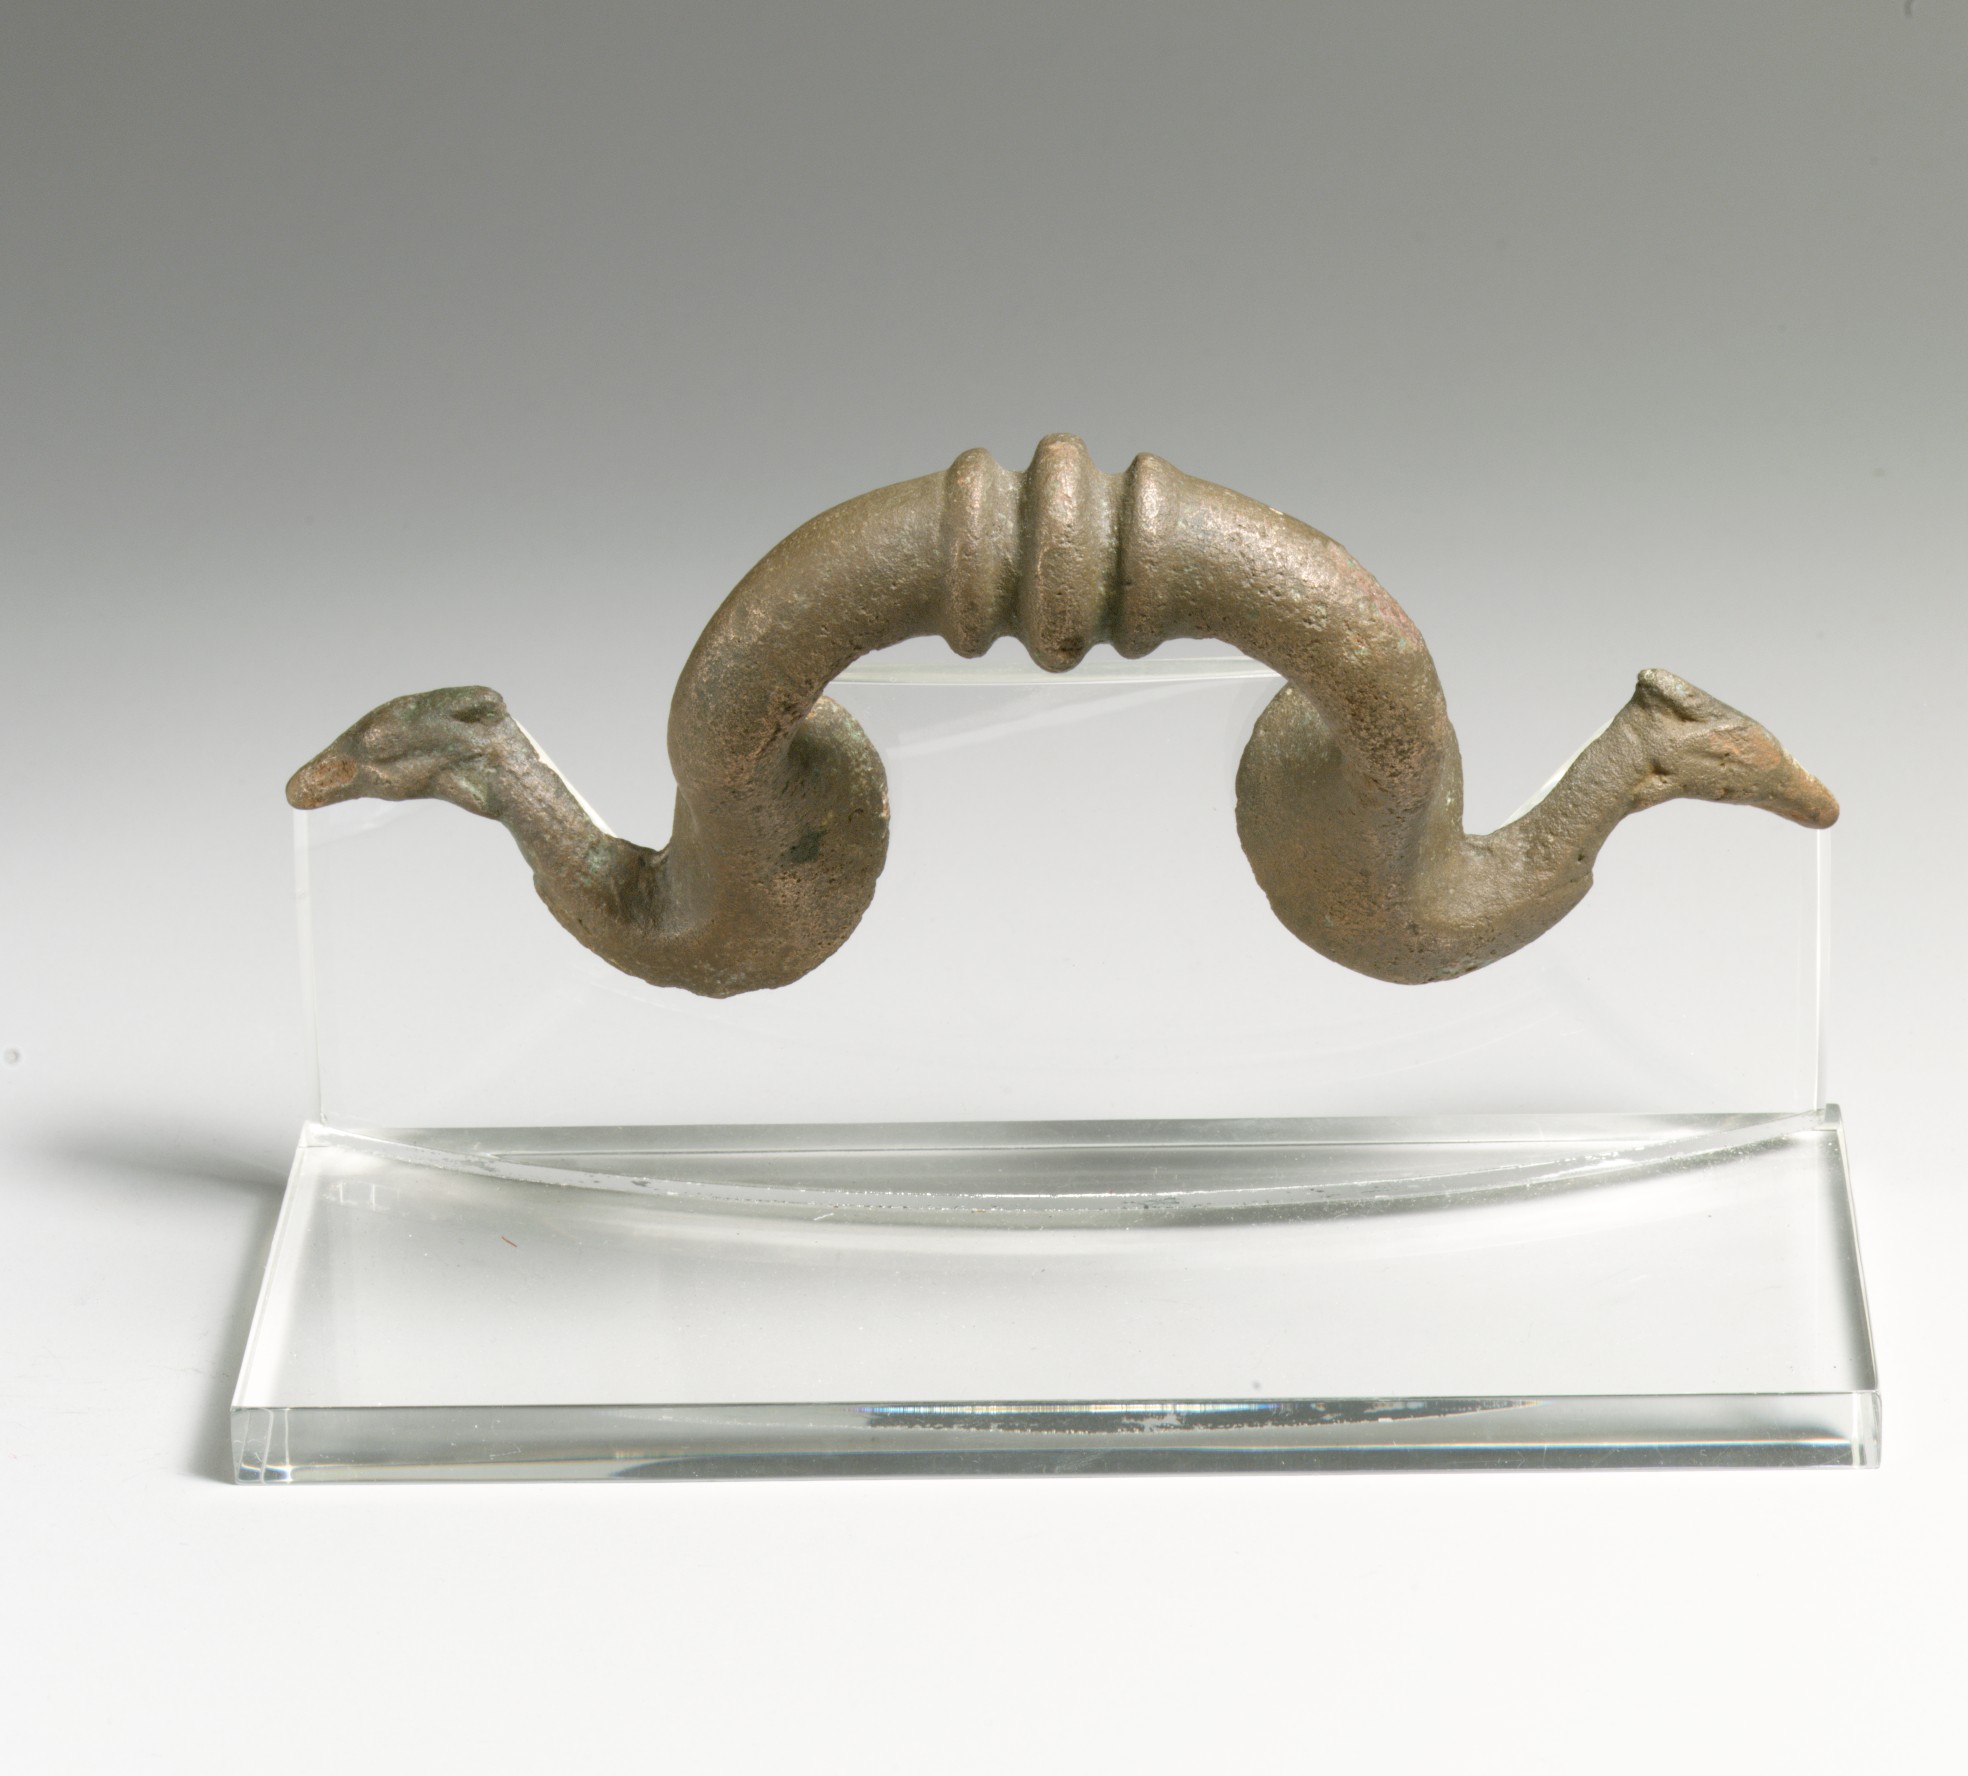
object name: handle of a bowl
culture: cypriot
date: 3900 BCE-100 CE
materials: bronze